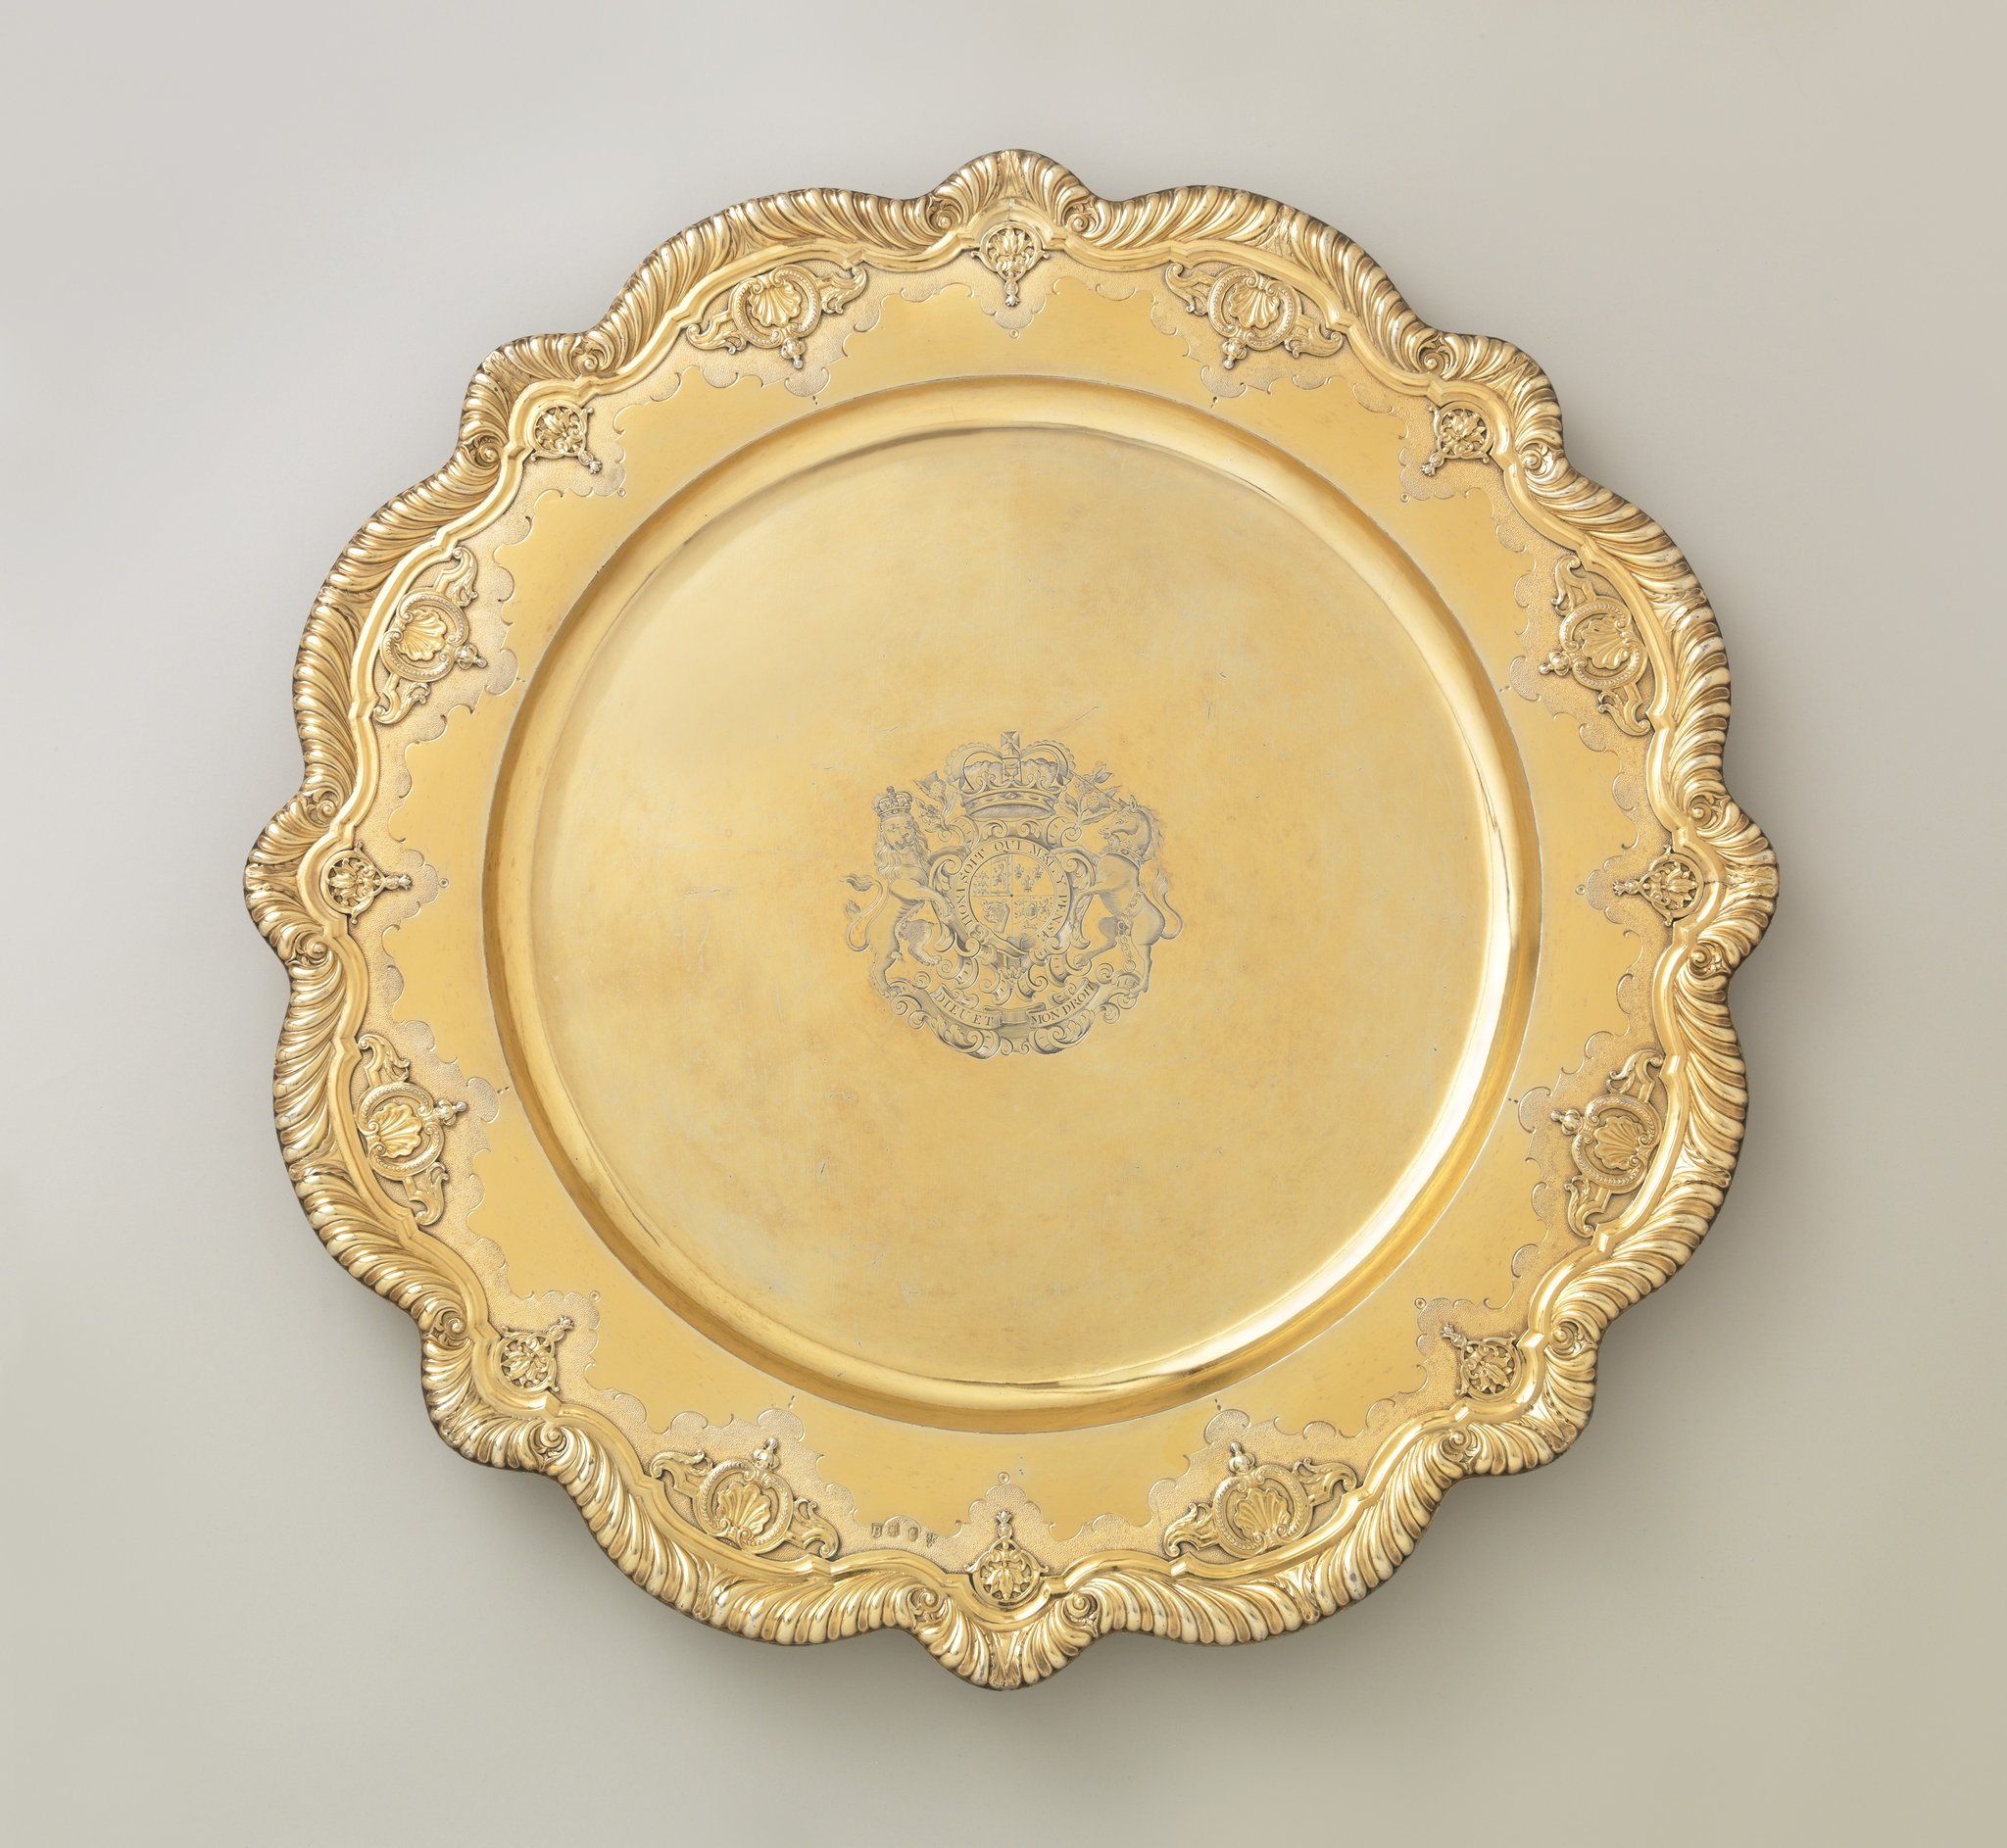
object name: sideboard dish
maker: lewis mettayer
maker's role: maker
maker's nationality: british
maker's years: 1640-1740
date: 1717-1718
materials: silver gilt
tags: unicorns,lions,coat of arms